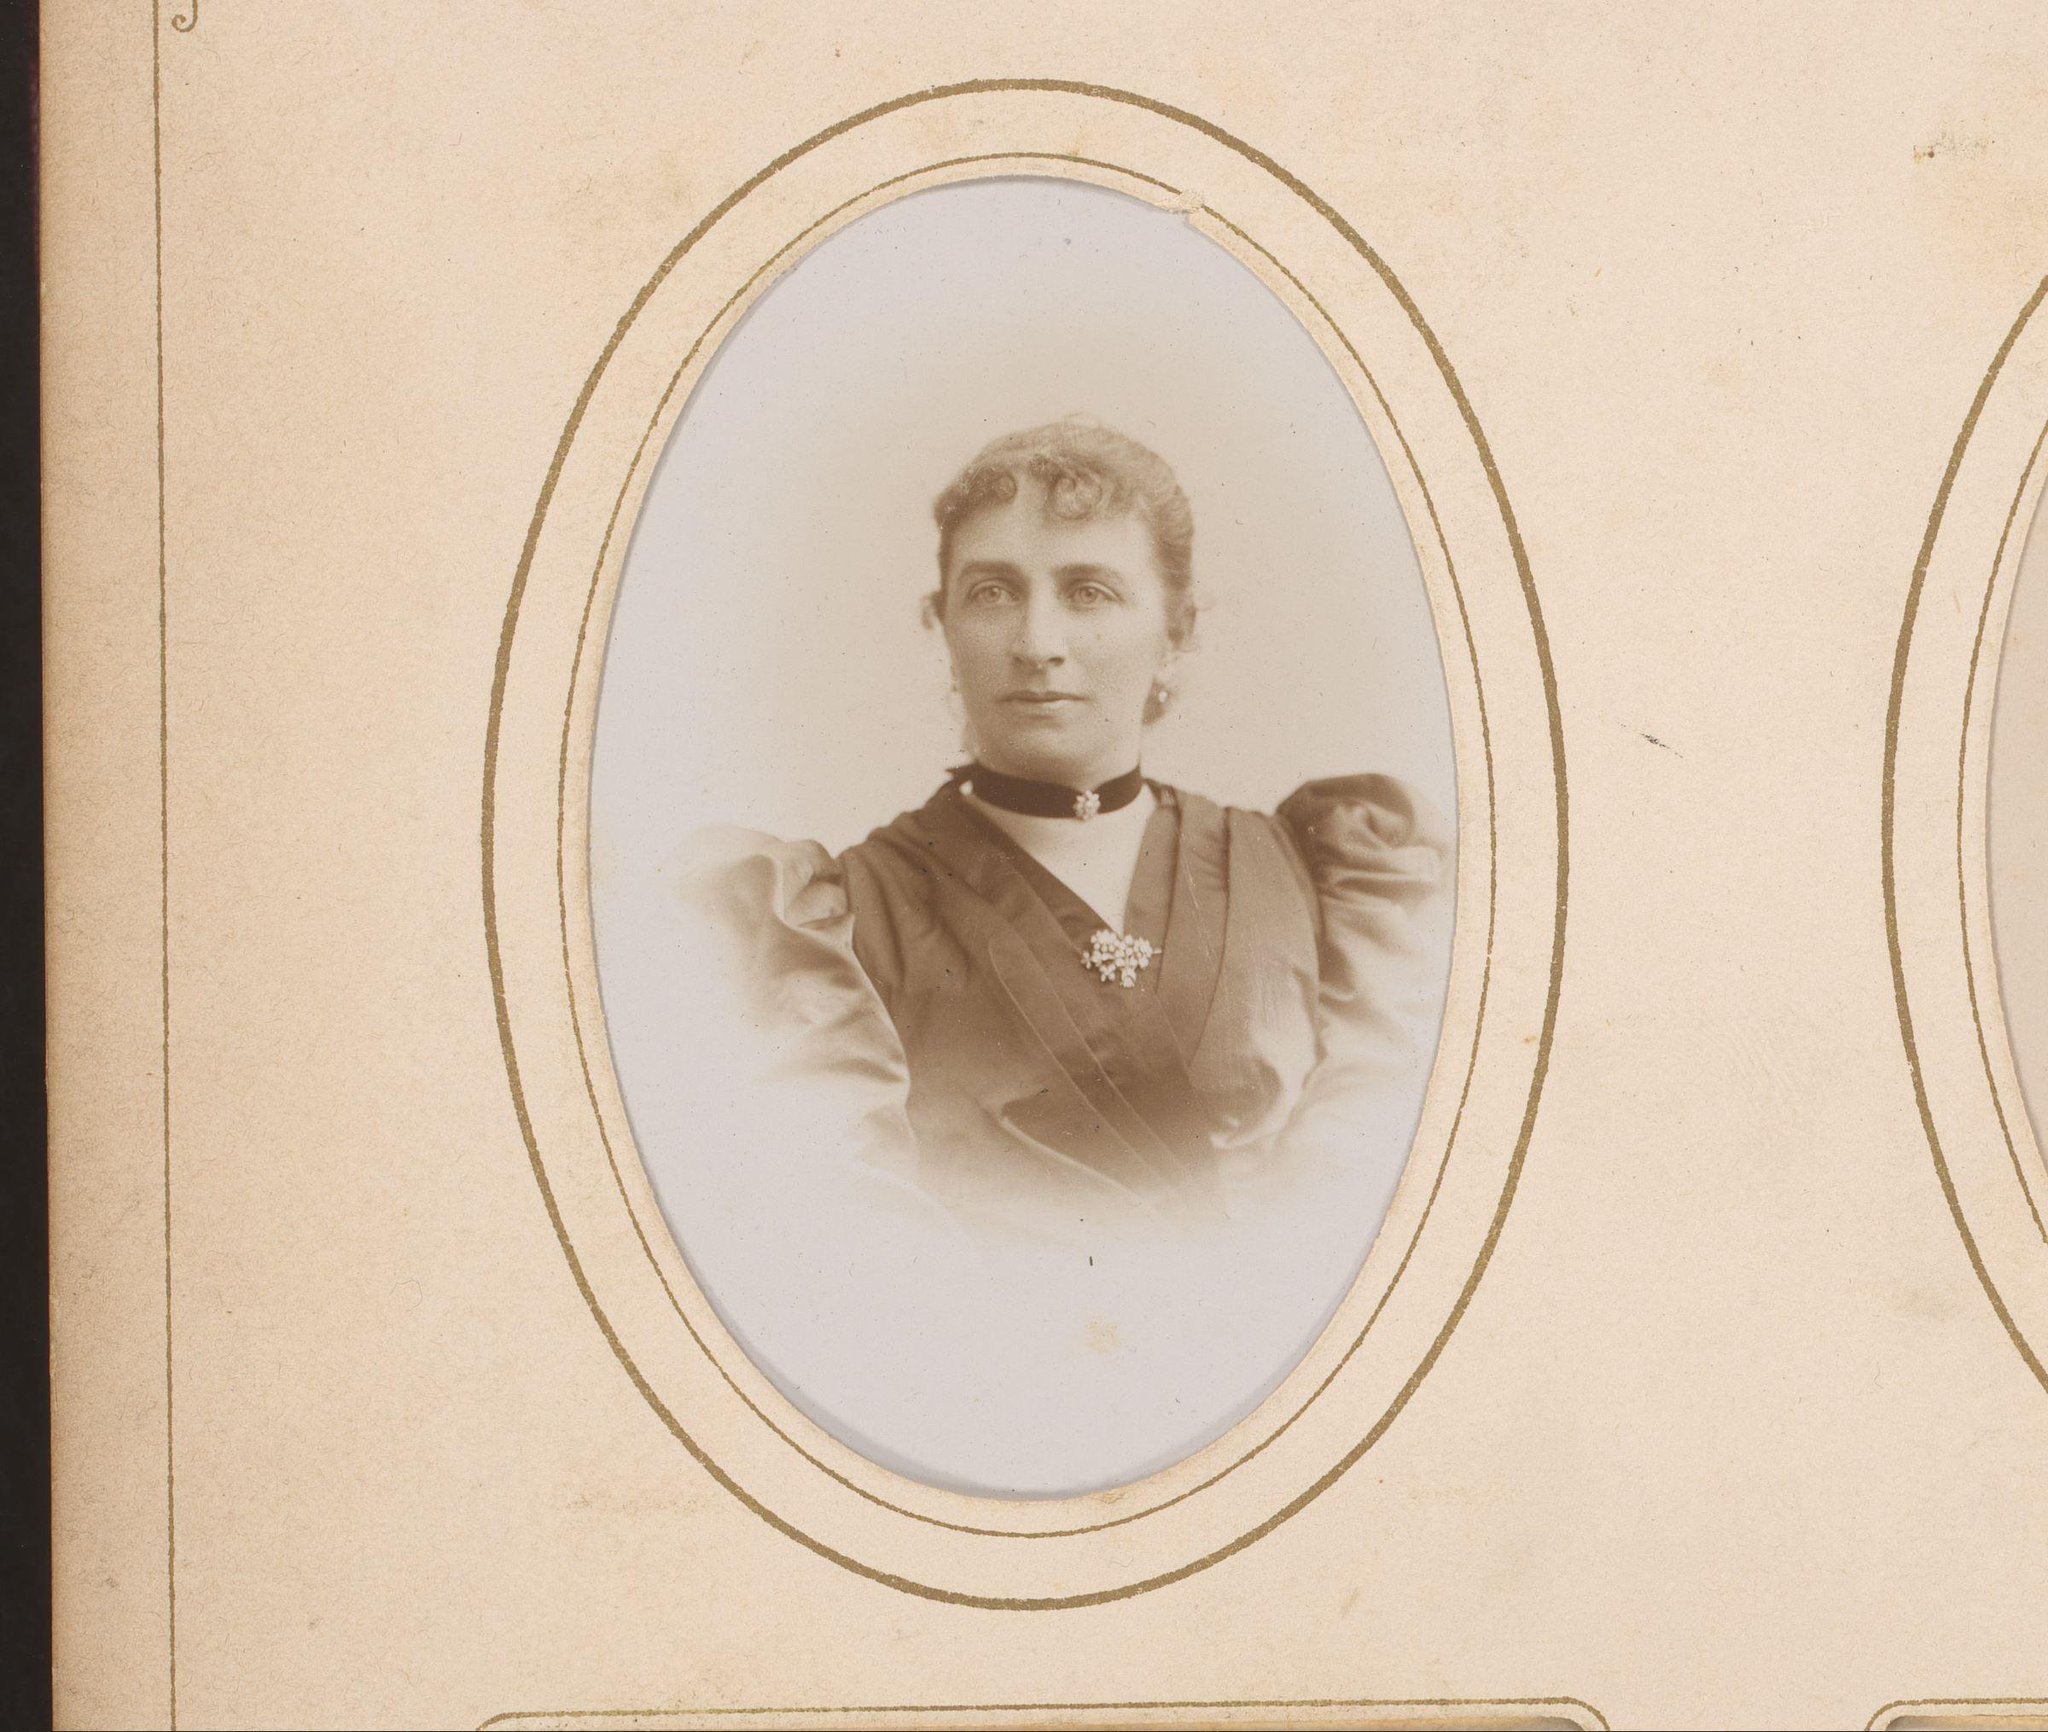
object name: album leaf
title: Portret van een vrouw met halsketting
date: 1881-1901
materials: cardboard, photographic support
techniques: collodion silver print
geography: haarlem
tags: historical persons - bb - woman, necklace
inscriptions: inscription: ‘(...)/ C.F. & L.J. Cordes/ Haarlem/ Groote Houtstraat 84,/ 's Bosch a/d. Parade./ Op verschillende tentoonstellingen bekroond voor Vergrootingen/ in kooldruk en andere photographien./ Met de hoogste onderscheiding op de Tentoonstelling van/ Kunstnijverheid te 's Hage./ De clichés blijven ter nabestelling bewaard./ Specialiteit in Kooldruk Vergrootingen.’